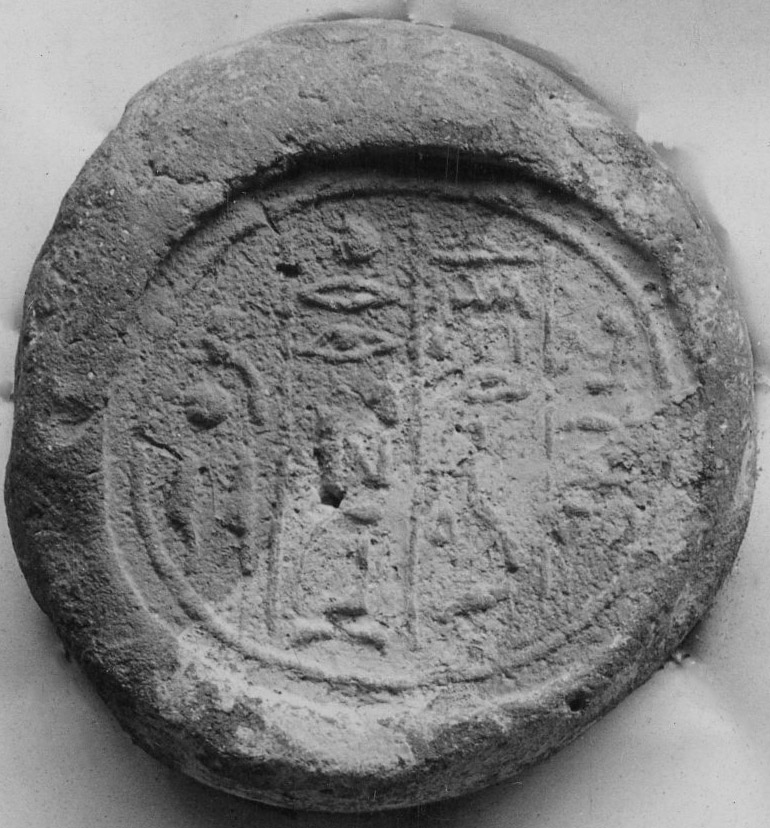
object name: cone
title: Funerary Cones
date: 1550-1295 BCE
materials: pottery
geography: egypt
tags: hieroglyphs